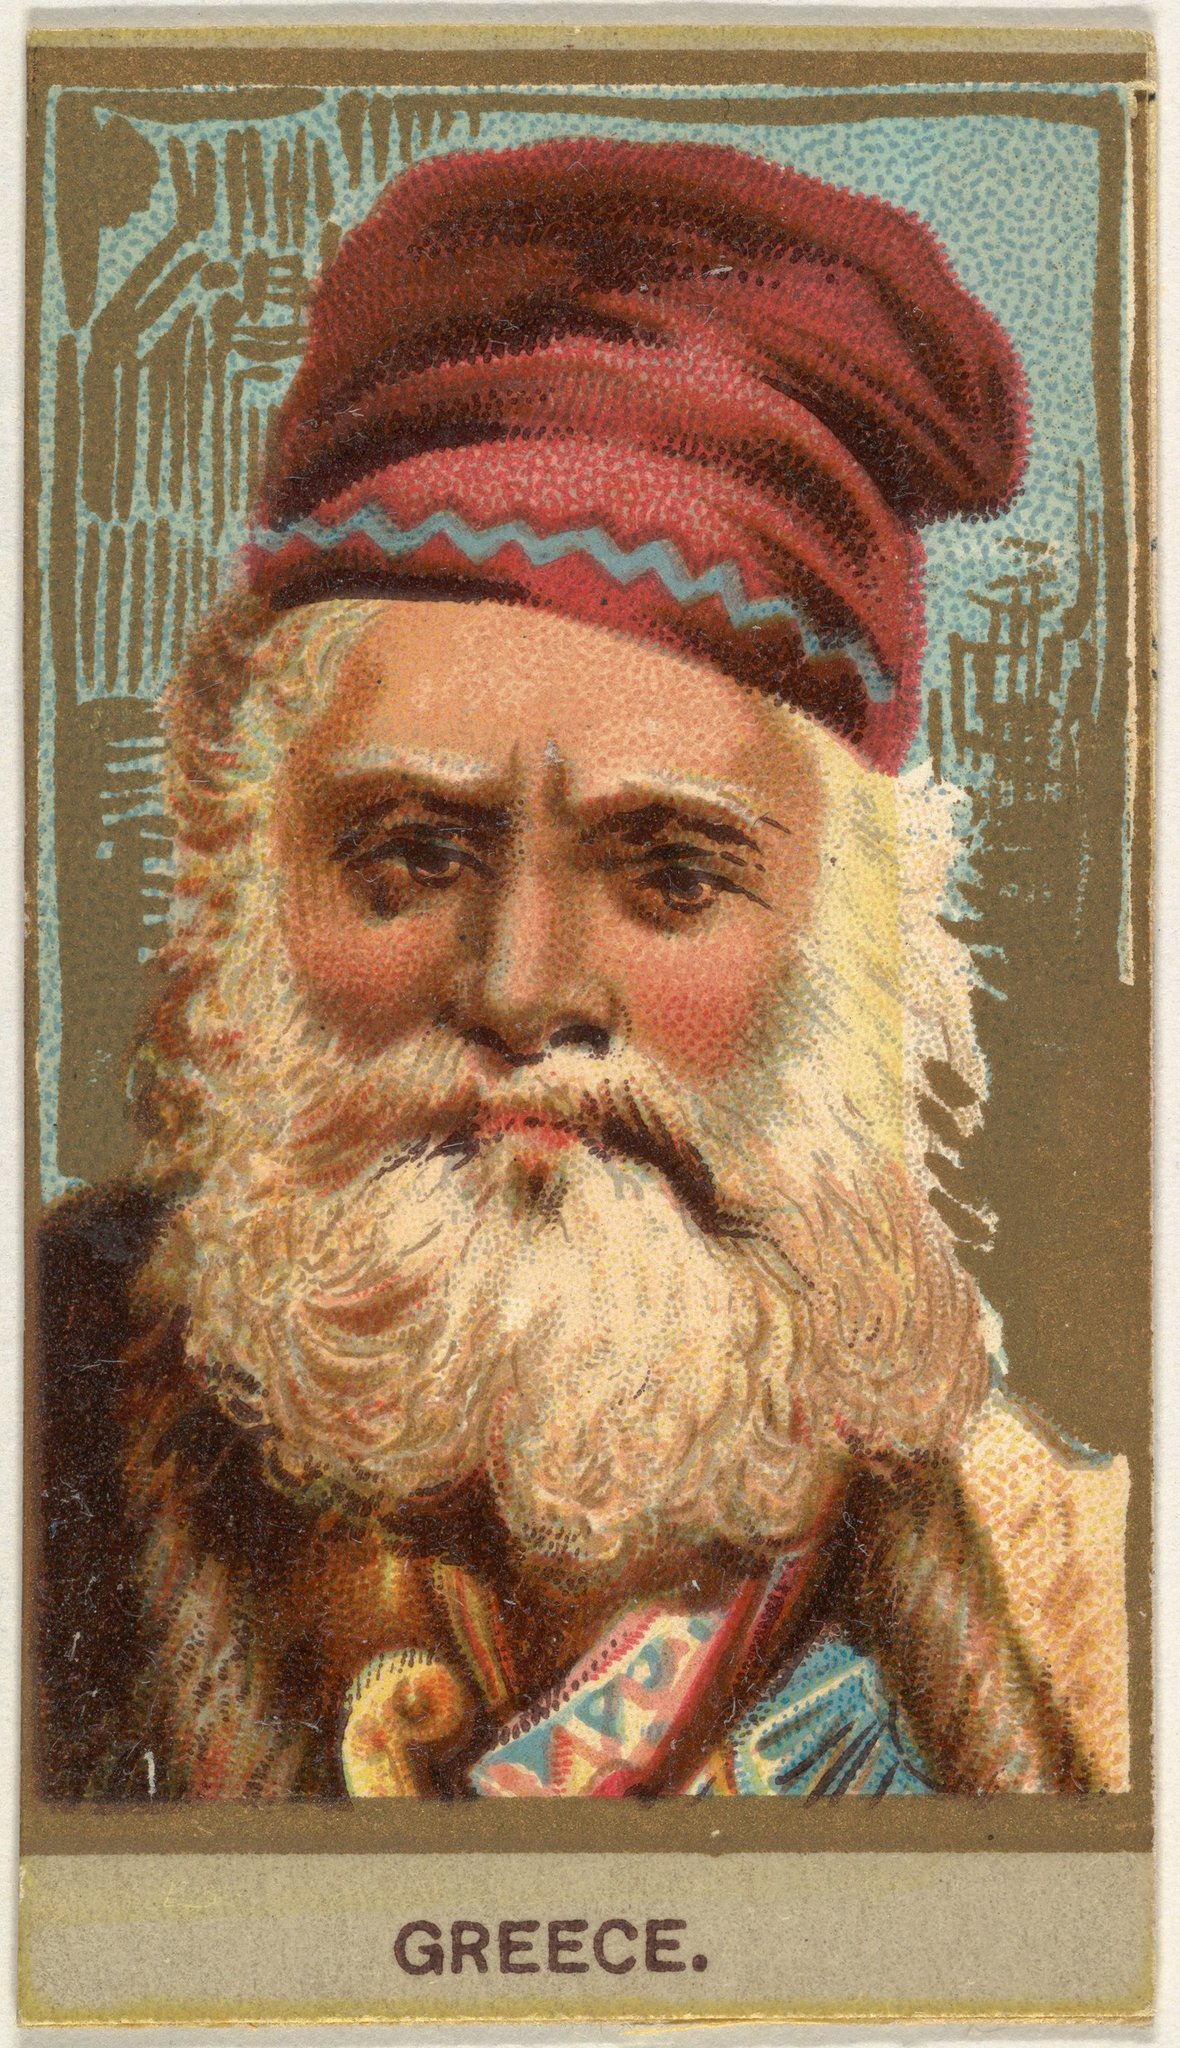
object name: print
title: Greece, from the Races of Mankind series (T181) issued by Abdul Cigarettes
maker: abdul cigarettes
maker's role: publisher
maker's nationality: american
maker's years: 1881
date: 1881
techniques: color lithograph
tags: men